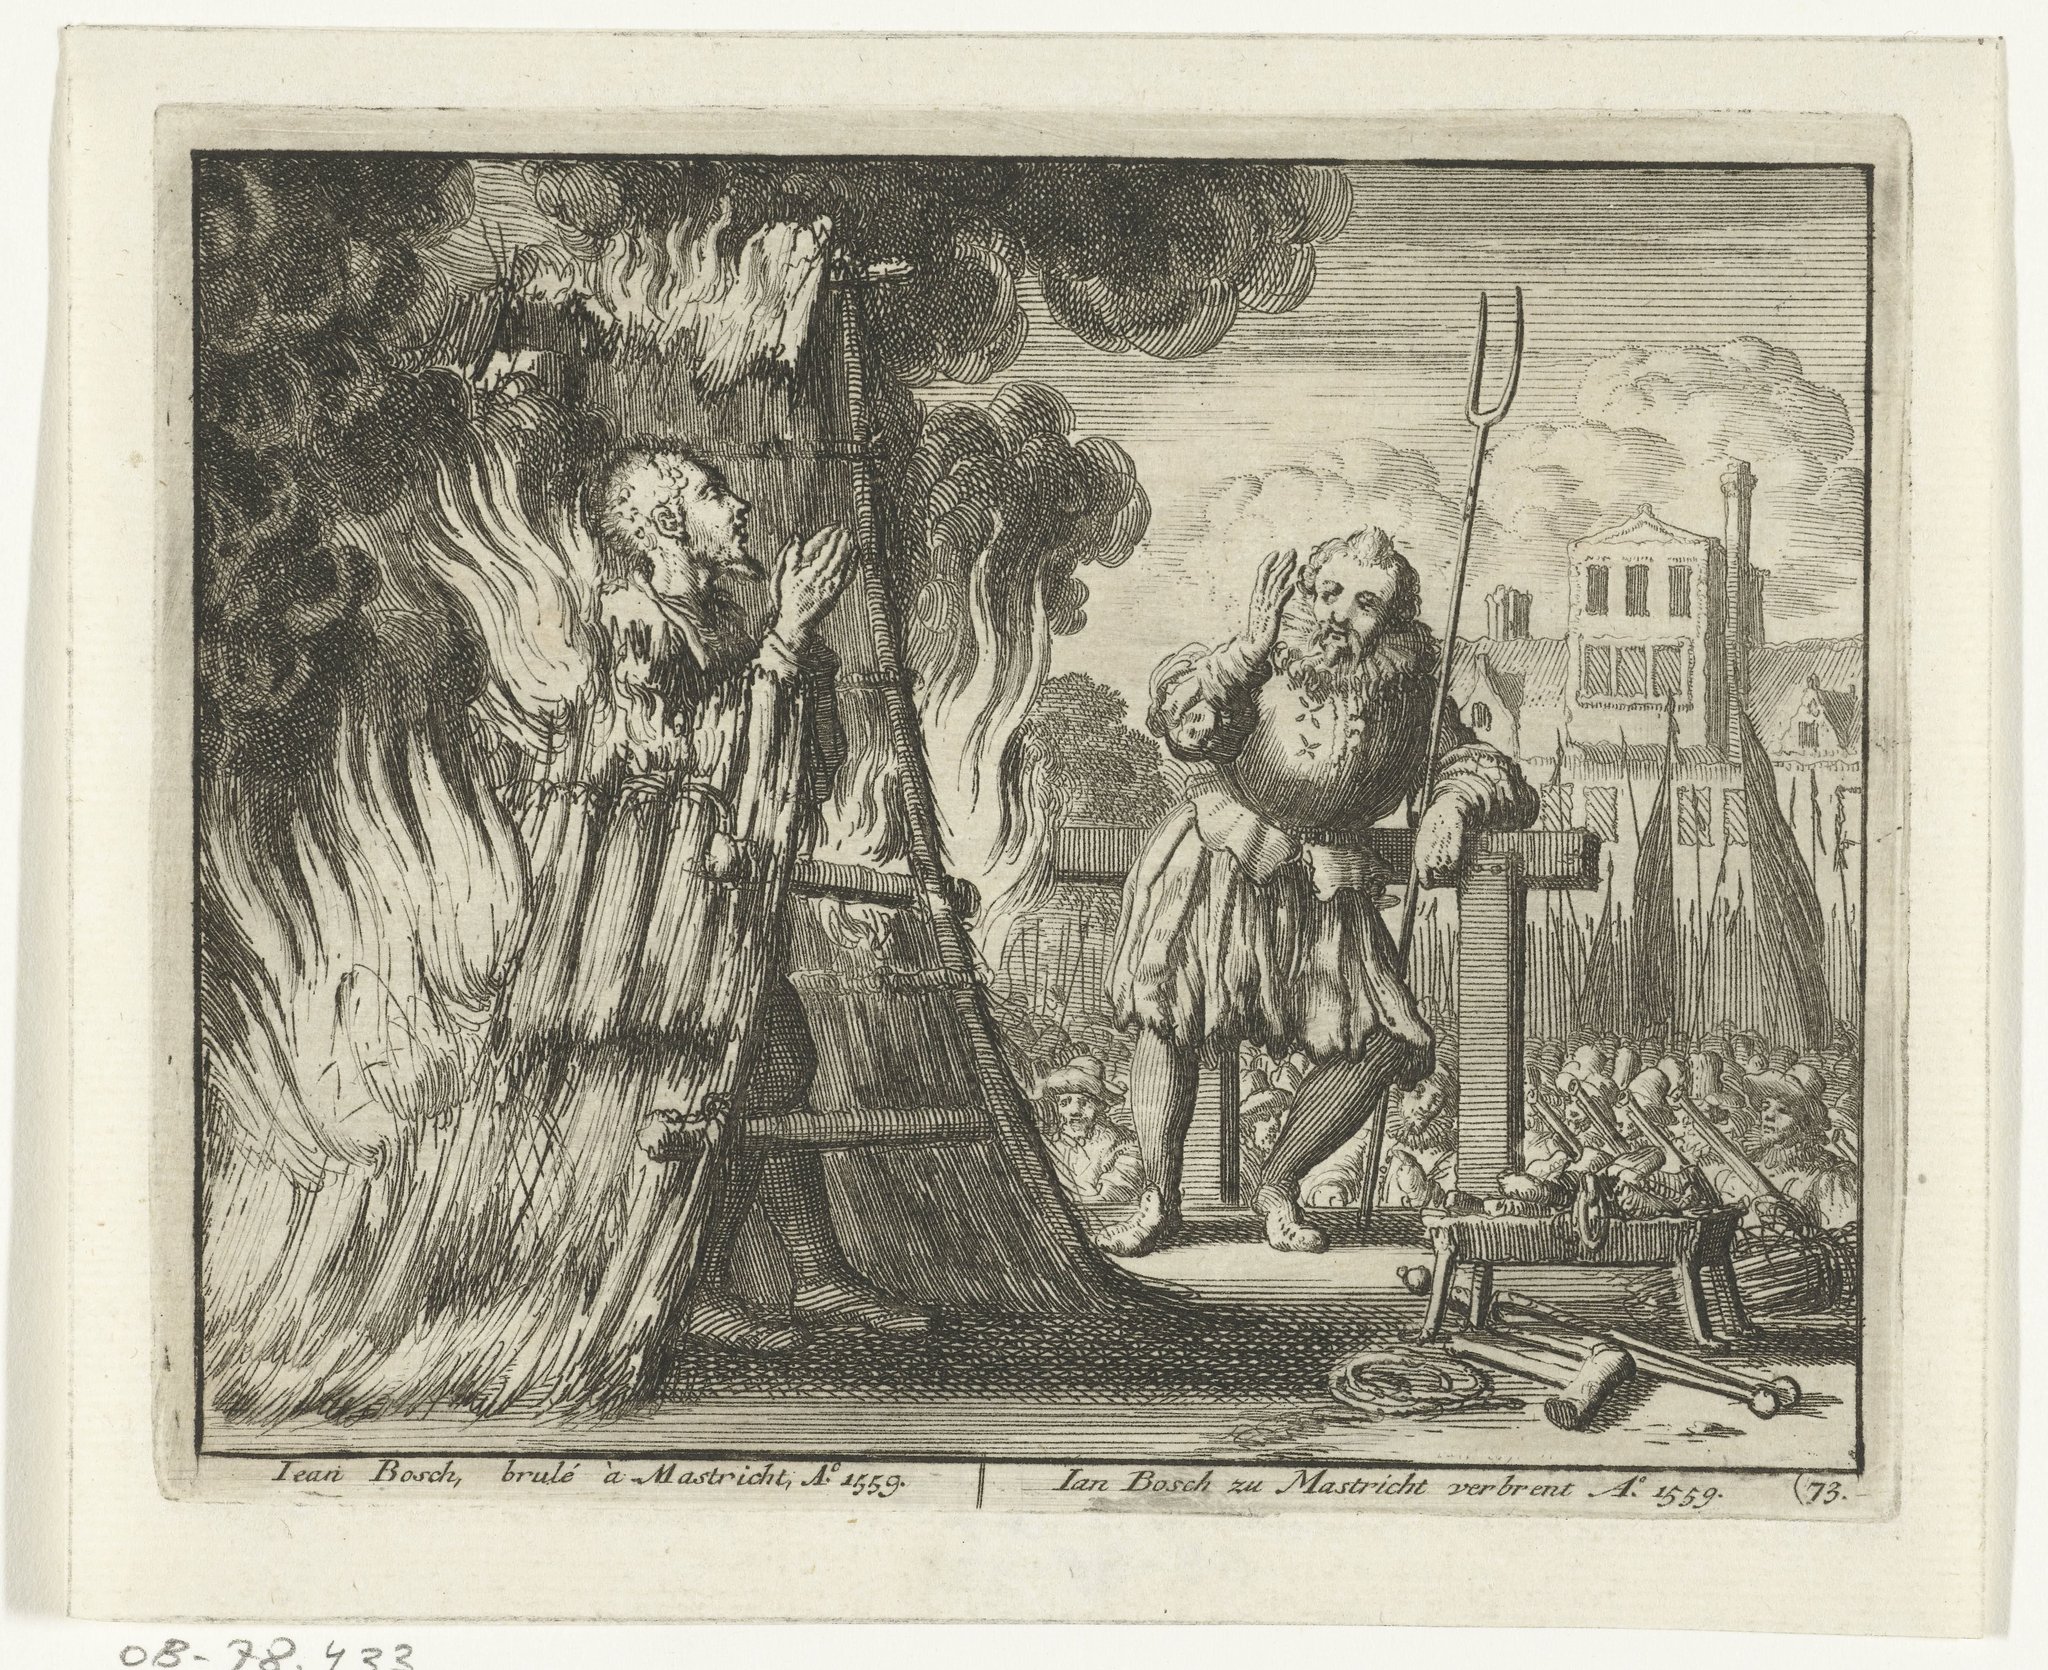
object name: print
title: Jean Bosch, brulé à Mastricht, Ao. 1559 / Jan Bosch zu Mastricht verbrent Ao. 1559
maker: jan luyken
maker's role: draughtsman, print maker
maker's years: 1649-1712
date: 1683-1685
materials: paper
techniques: etching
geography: northern netherlands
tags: execution of heretic, e.g. by burning at the stake, 'auto-da-fé', maastricht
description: Deze prent in de tweede staat gebruikt als illustratie voor: Theatre des martyrs, depuis la mort de J. Christ jusqu'à present (...). = Schau-buhne der Martyrer, P. van der Aa, Leiden ca. 1715, nr. 73. De prenten zijn oorspronkelijk vervaardigd voor en eerst gebruikt in: T.J. van Bragt, Het bloedig tooneel, of Martelaers spiegel der doops-gesinde of weereloose christenen, 1685.